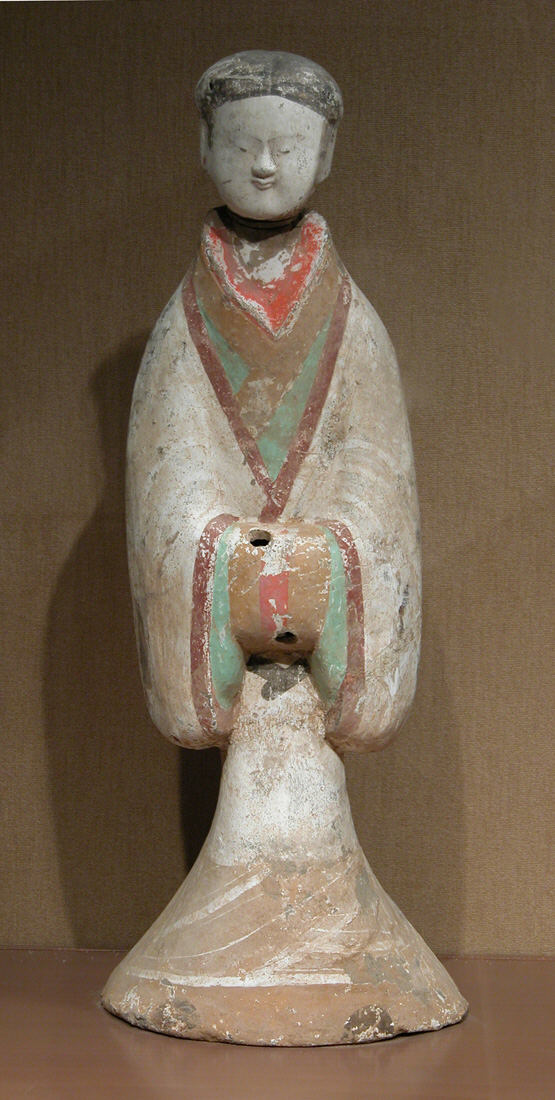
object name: standing lady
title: Standing Lady Attendant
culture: chinese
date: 206 BCE-9 CE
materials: earthenware, pigment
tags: women